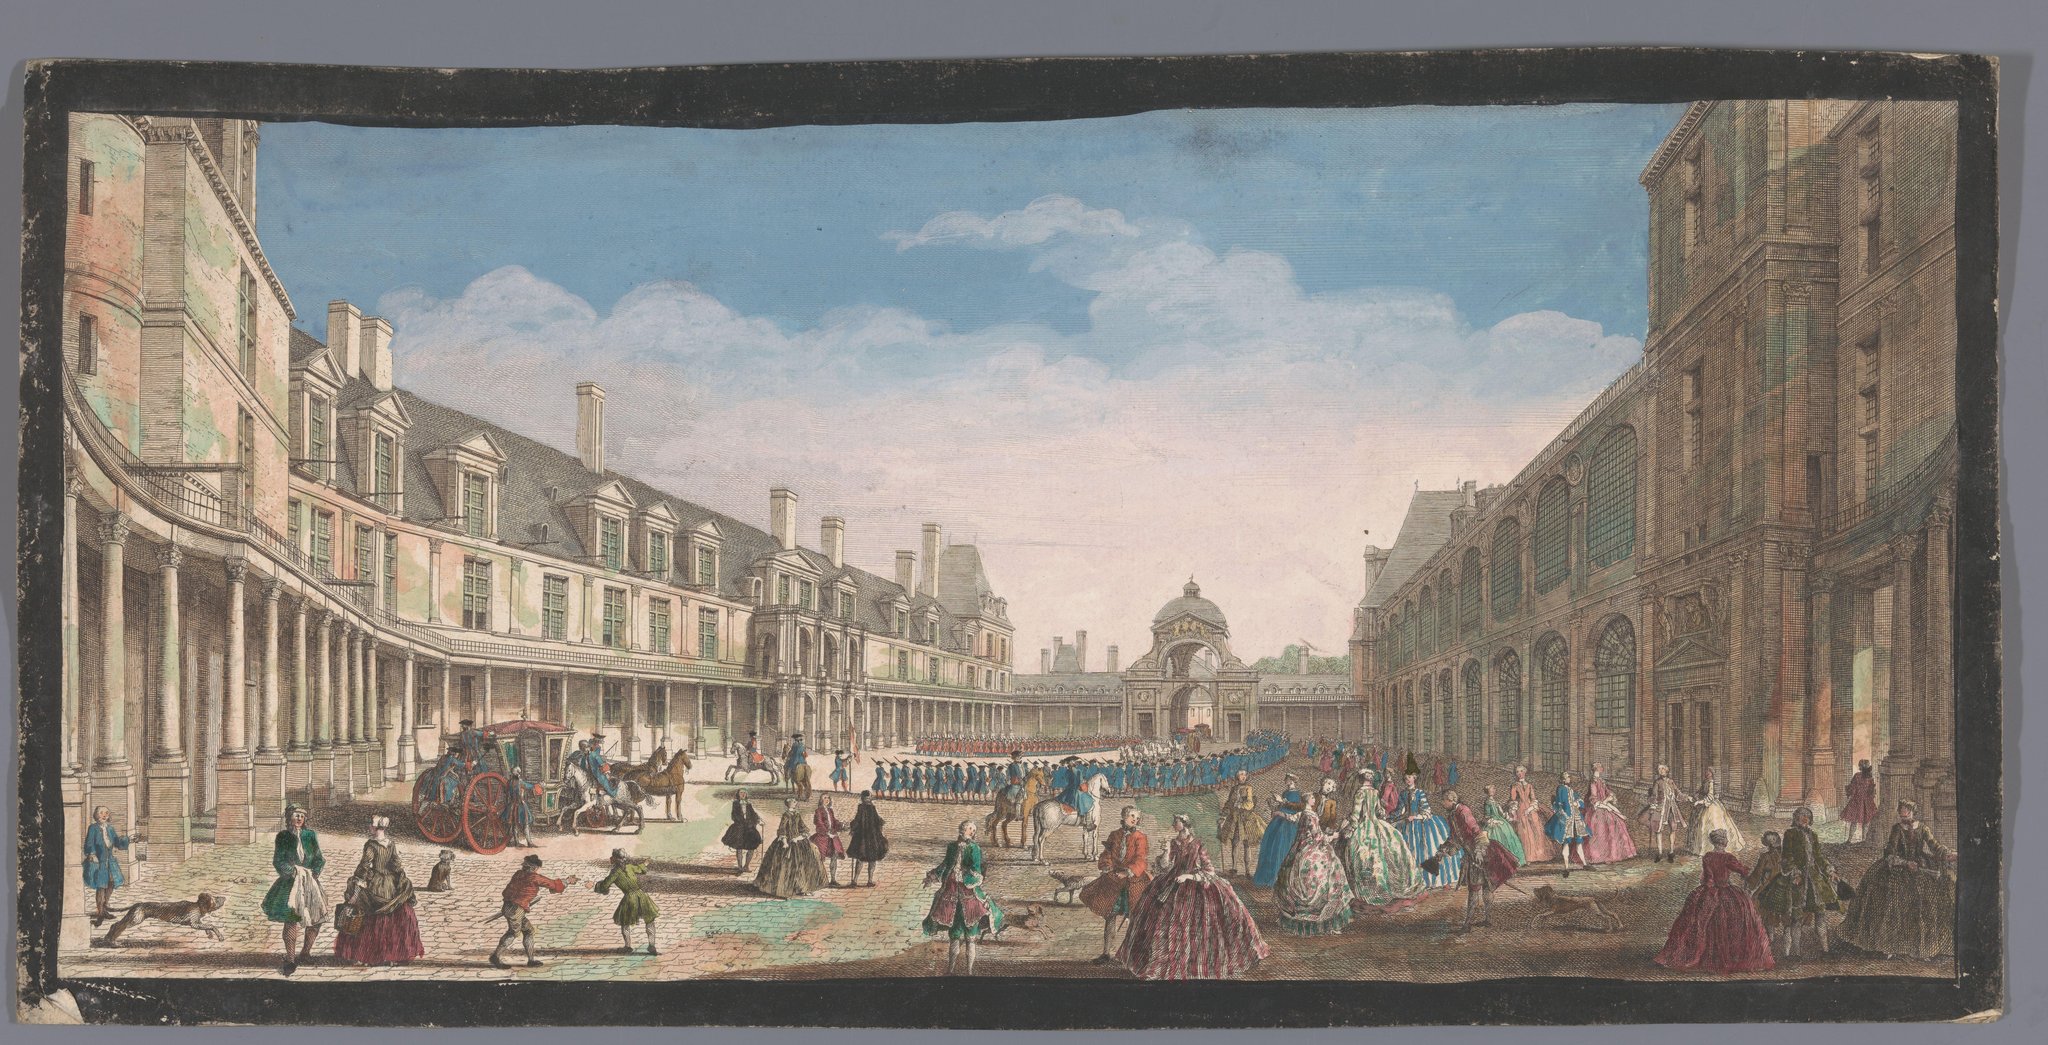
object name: opticaprent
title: Veüe de la Cour Ovale de Fontainebleau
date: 1700-1799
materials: cardboard, paper, watercolor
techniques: brush, etching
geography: paris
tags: palace, inner court of palace or 'hôtel'